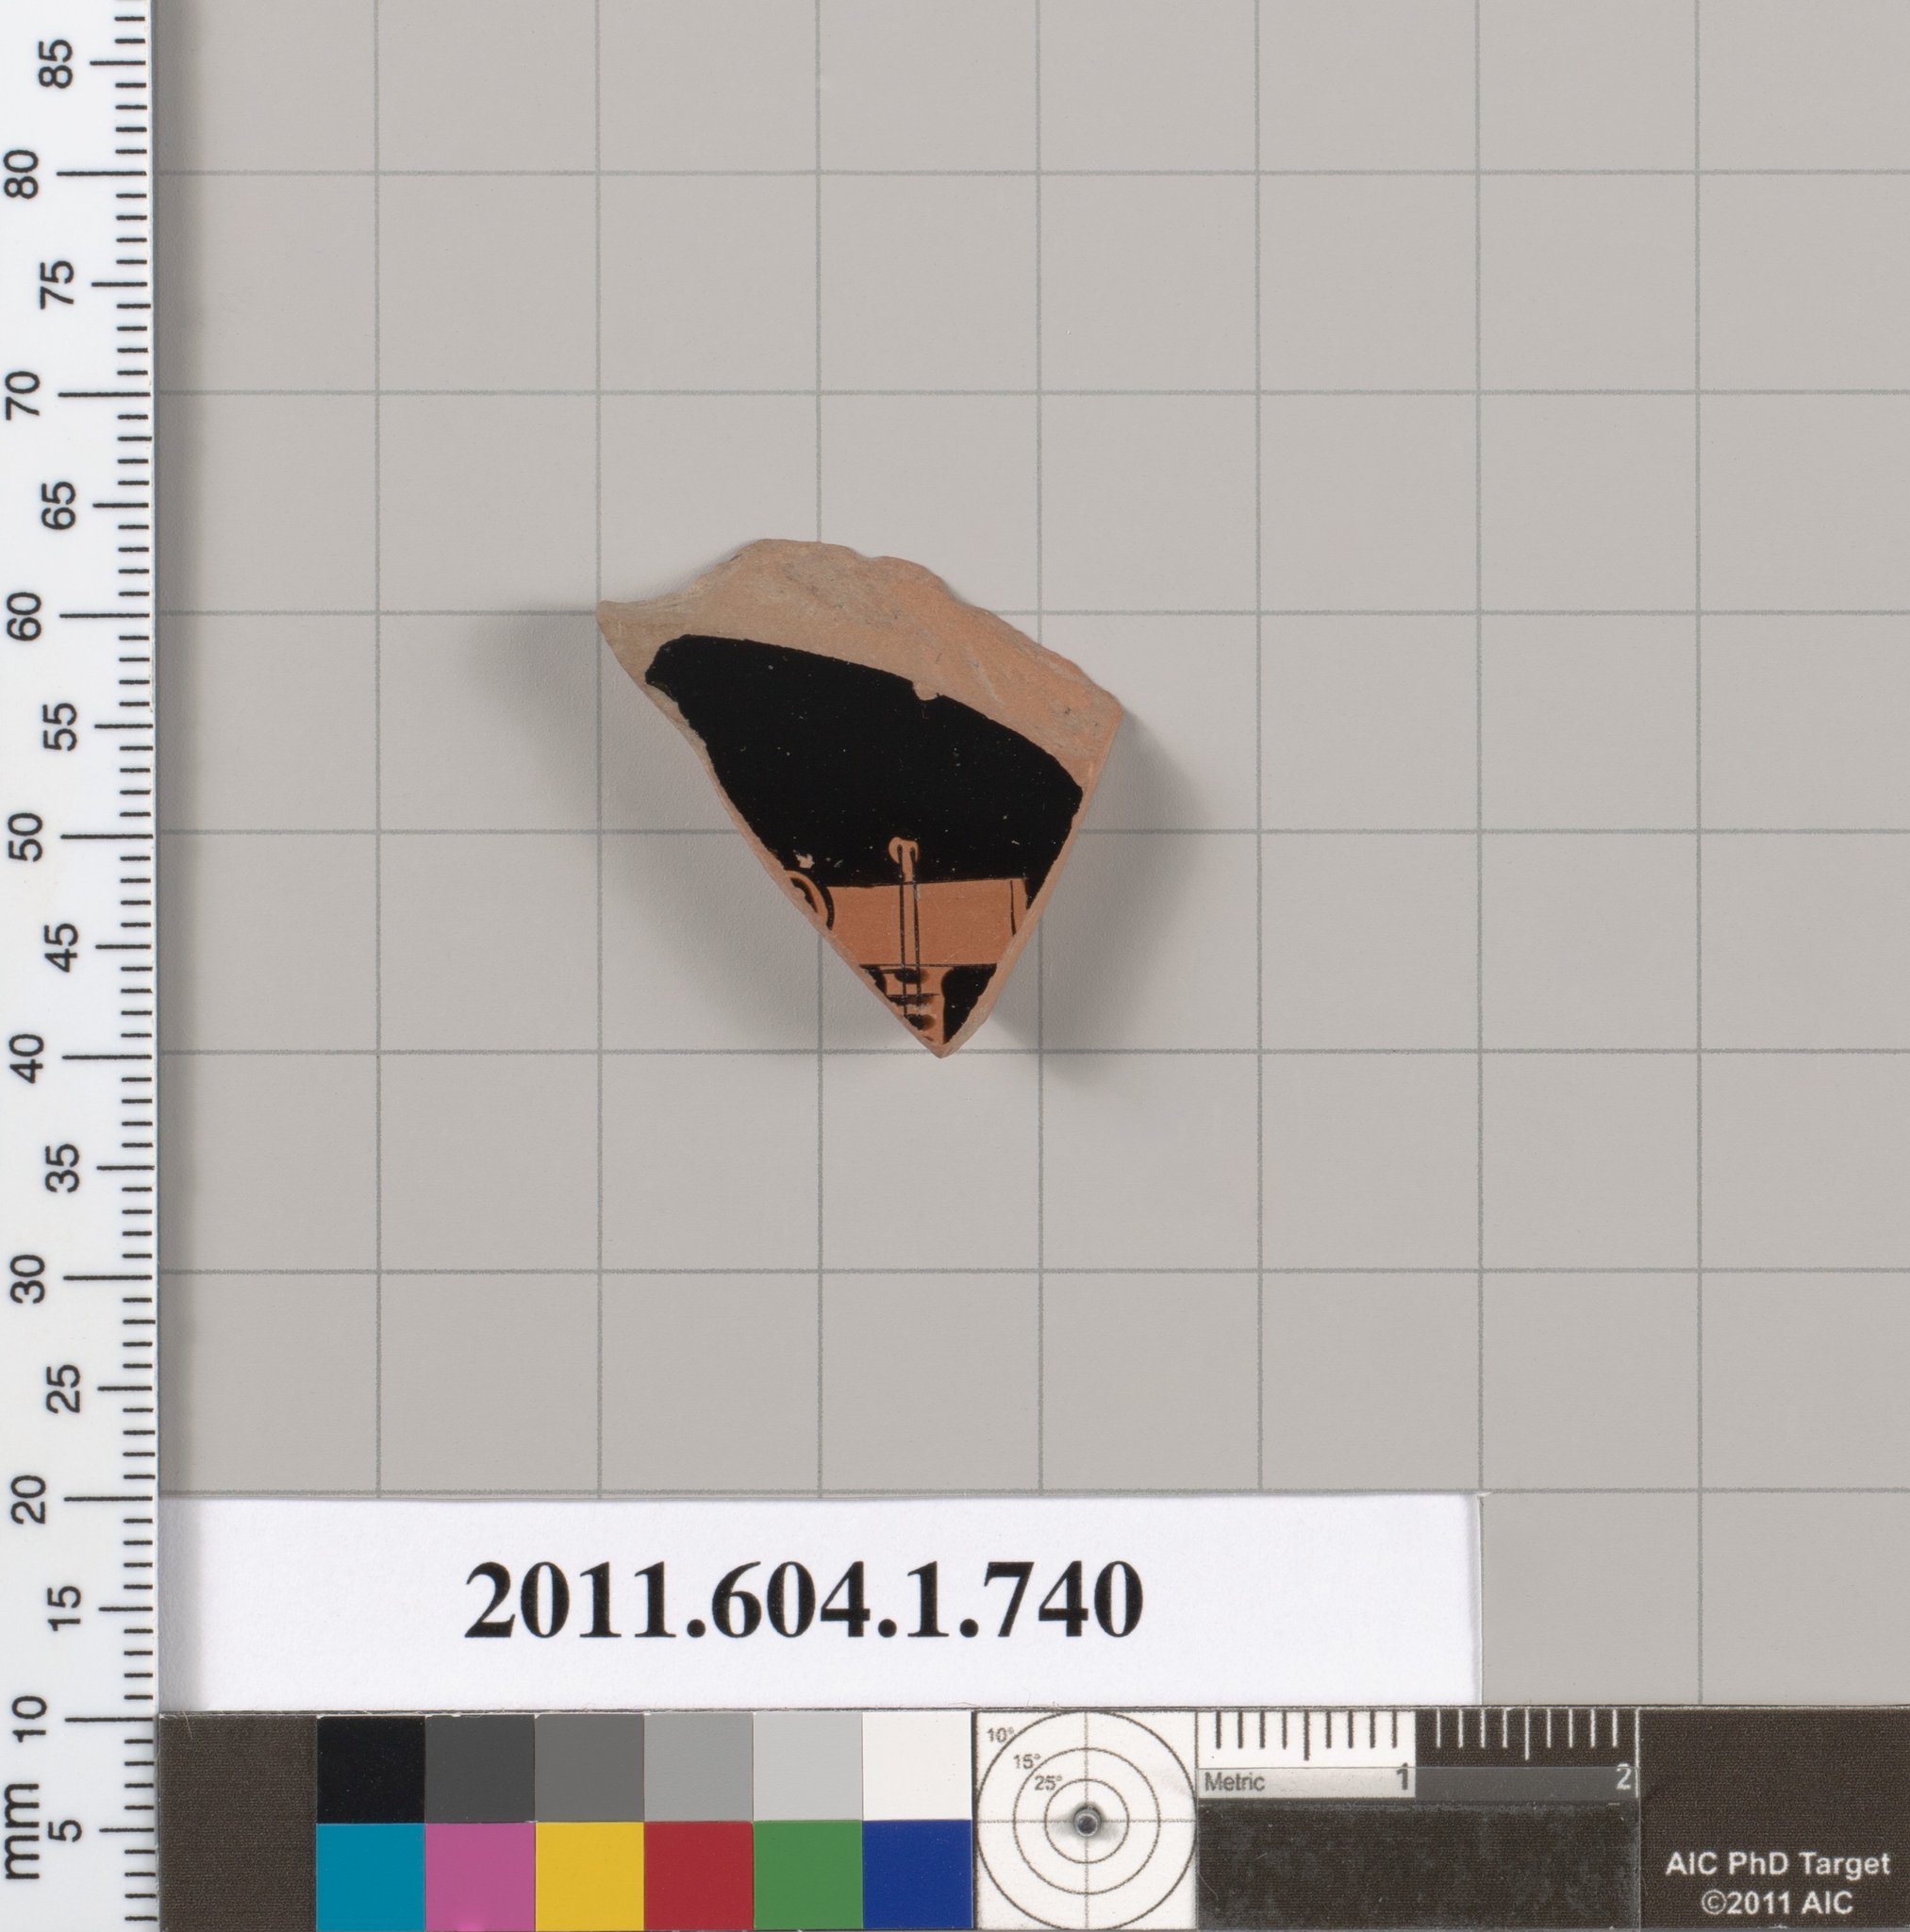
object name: kylix fragment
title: Terracotta fragment of a kylix (drinking cup)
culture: greek, attic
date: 490 BCE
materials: terracotta